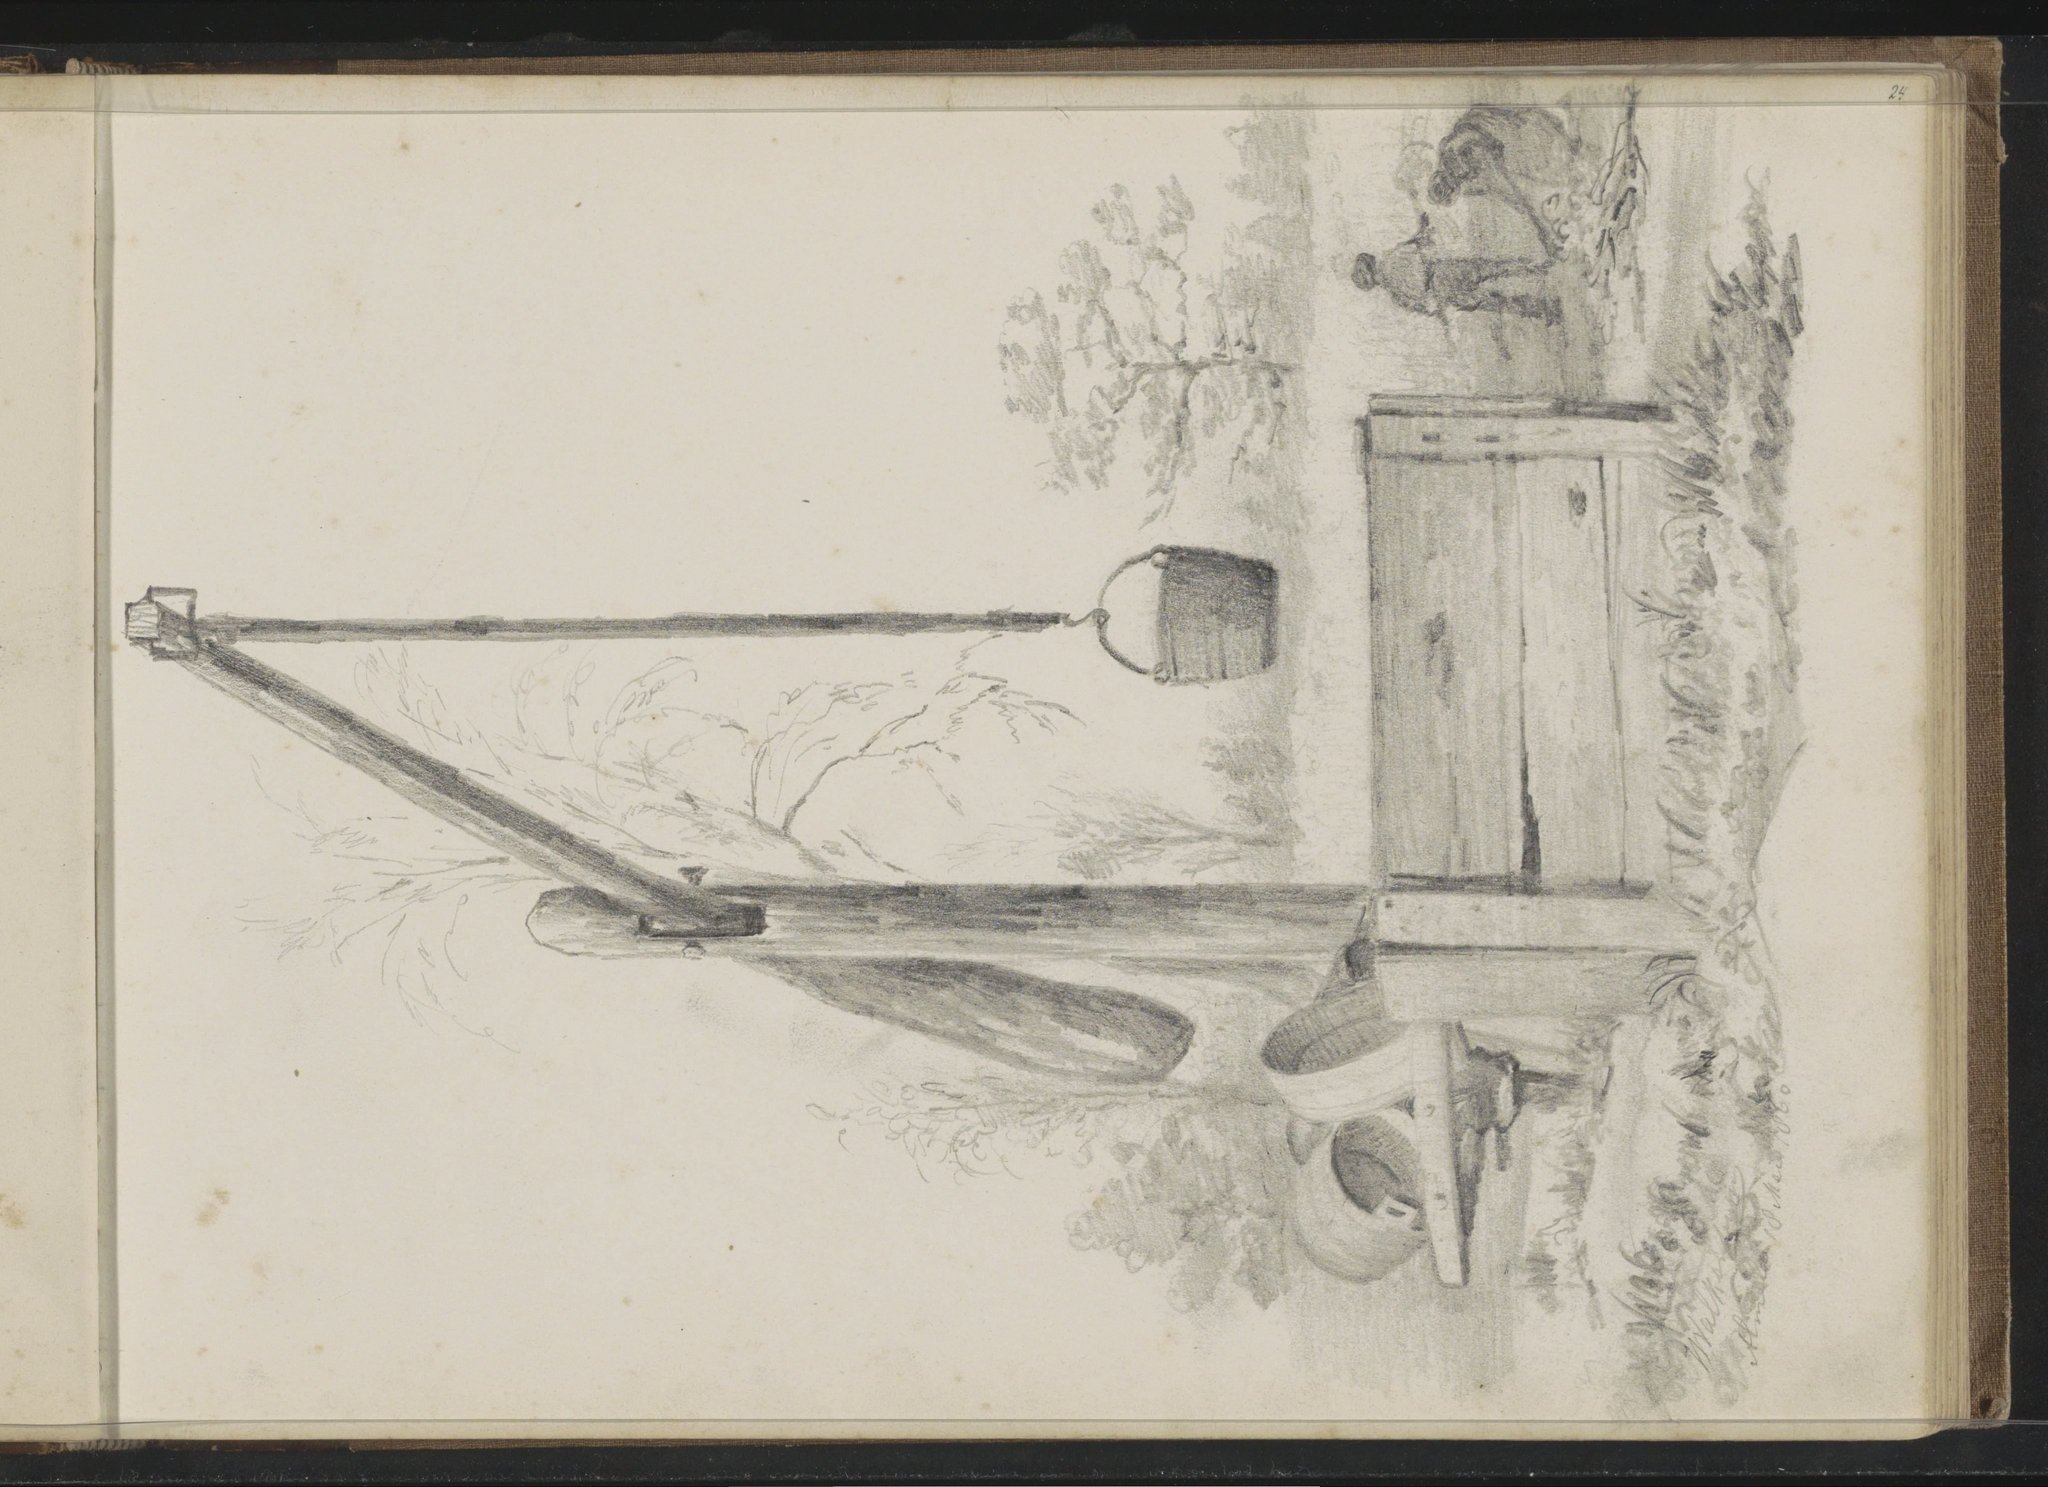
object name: sketchbook leaf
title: Waterput te Almelo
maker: hendrik valkenburg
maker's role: draughtsman, painter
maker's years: 1826-1896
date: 1805-1860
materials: paper, pencil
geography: almelo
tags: raking, well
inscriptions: date and inscription: ‘Almelo 18 Mei 1860’, signature: ‘HValkenburg’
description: Bij de put liggen emmers en schalen. Op de achtergrond twee figuren die met harken de grond bewerken. Blad 24 recto uit een schetsboek met 77 bladen.